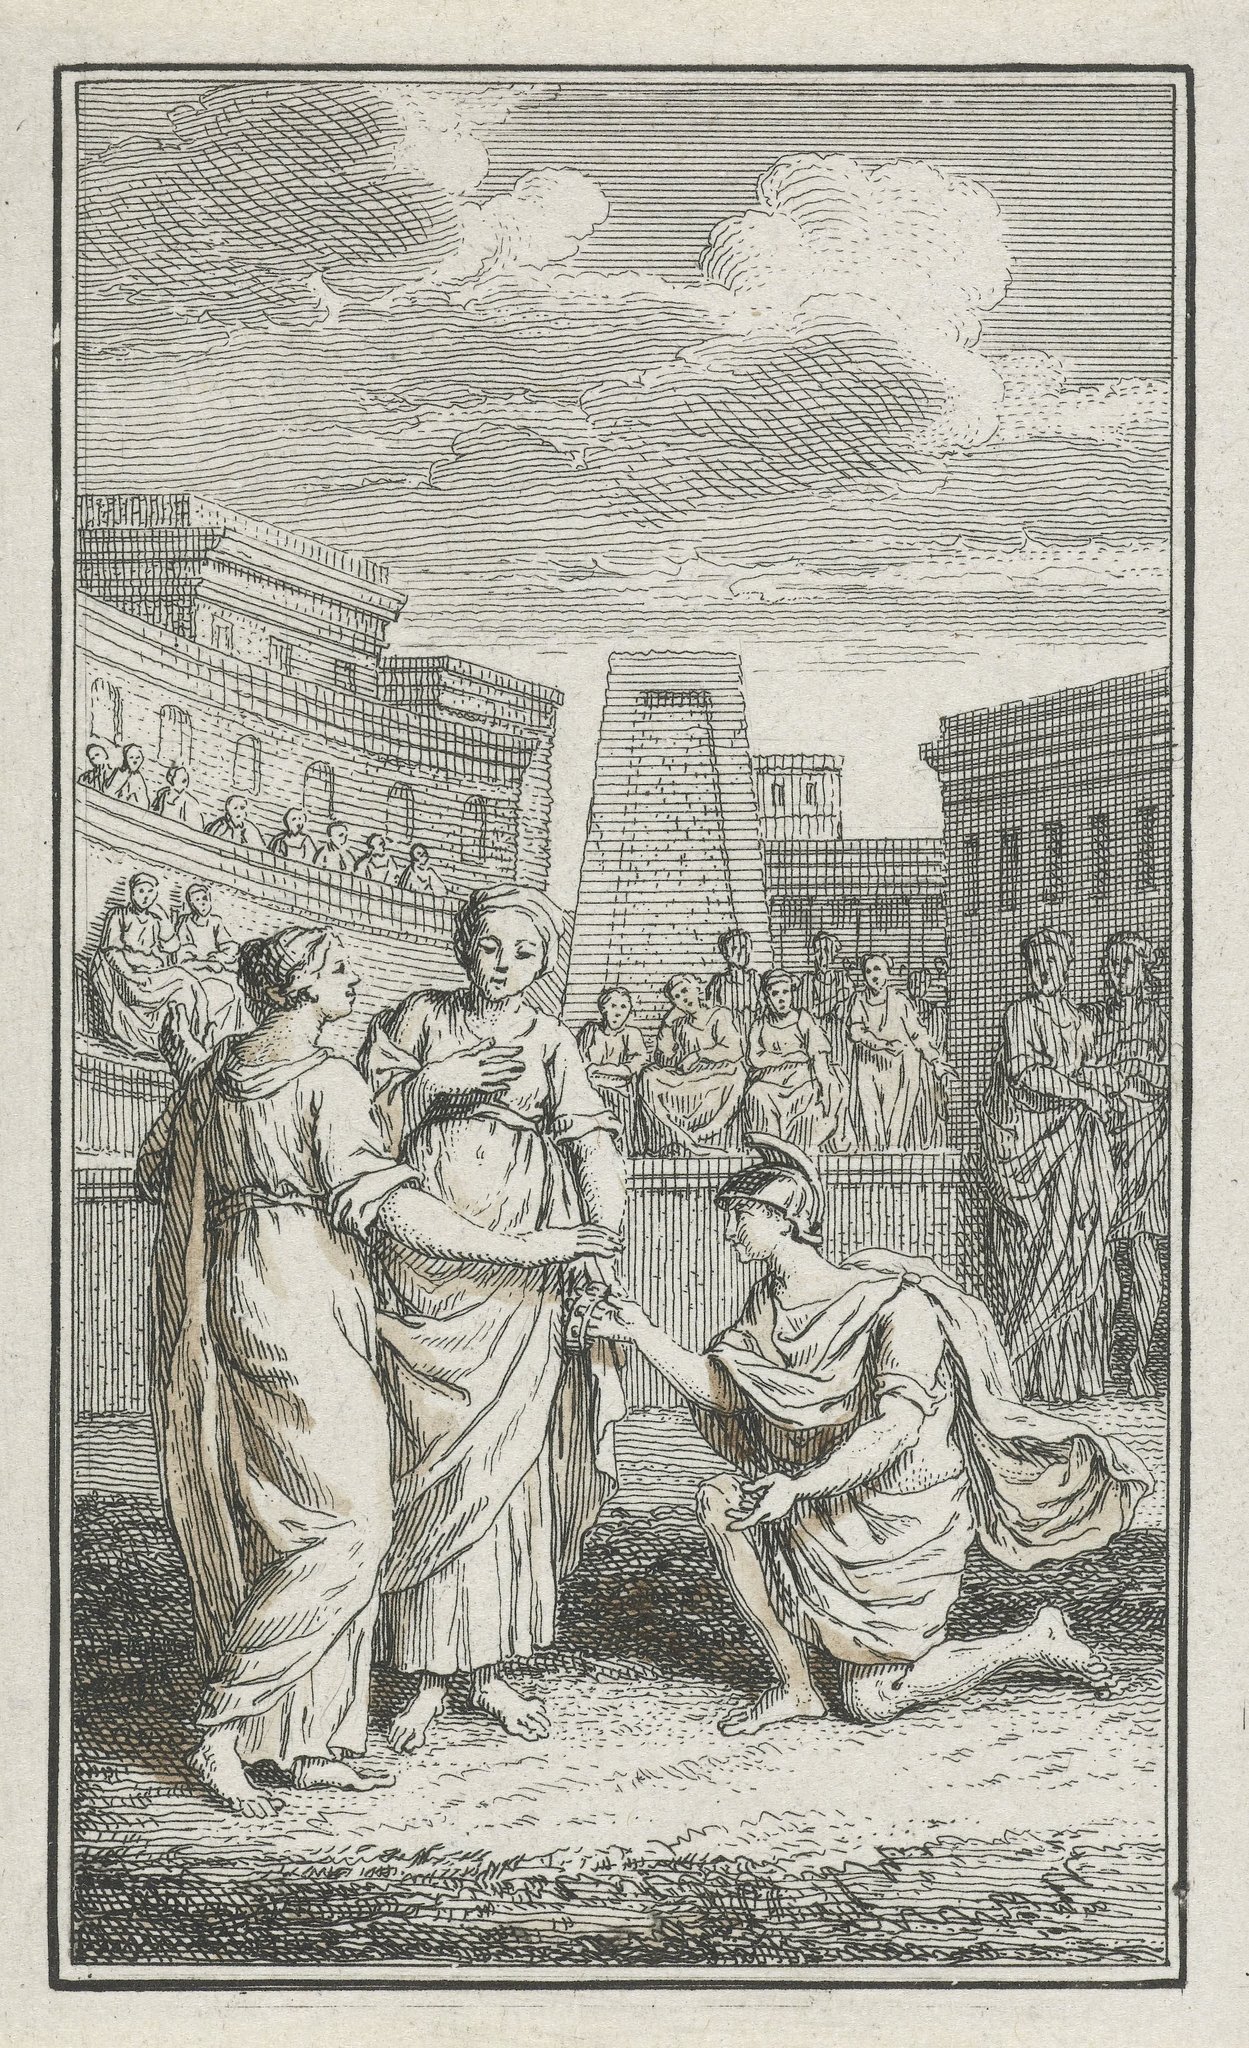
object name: print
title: Romeinse soldaat knielt voor een vrouw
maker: jacob folkema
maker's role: draughtsman, print maker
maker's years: 1692-1767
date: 1703-1767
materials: paper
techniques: brush, etching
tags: man kneeling before his beloved (proposing)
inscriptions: collector's mark: Lugt 240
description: Een Romeinse soldaat knielt met een geschenk in zijn hand voor een vrouw. De vrouw die hiernaast staat, slaat dit tafereel gade en houdt hierbij haar hand op haar borst. Op de achtergrond kijken eveneens figuren toe.